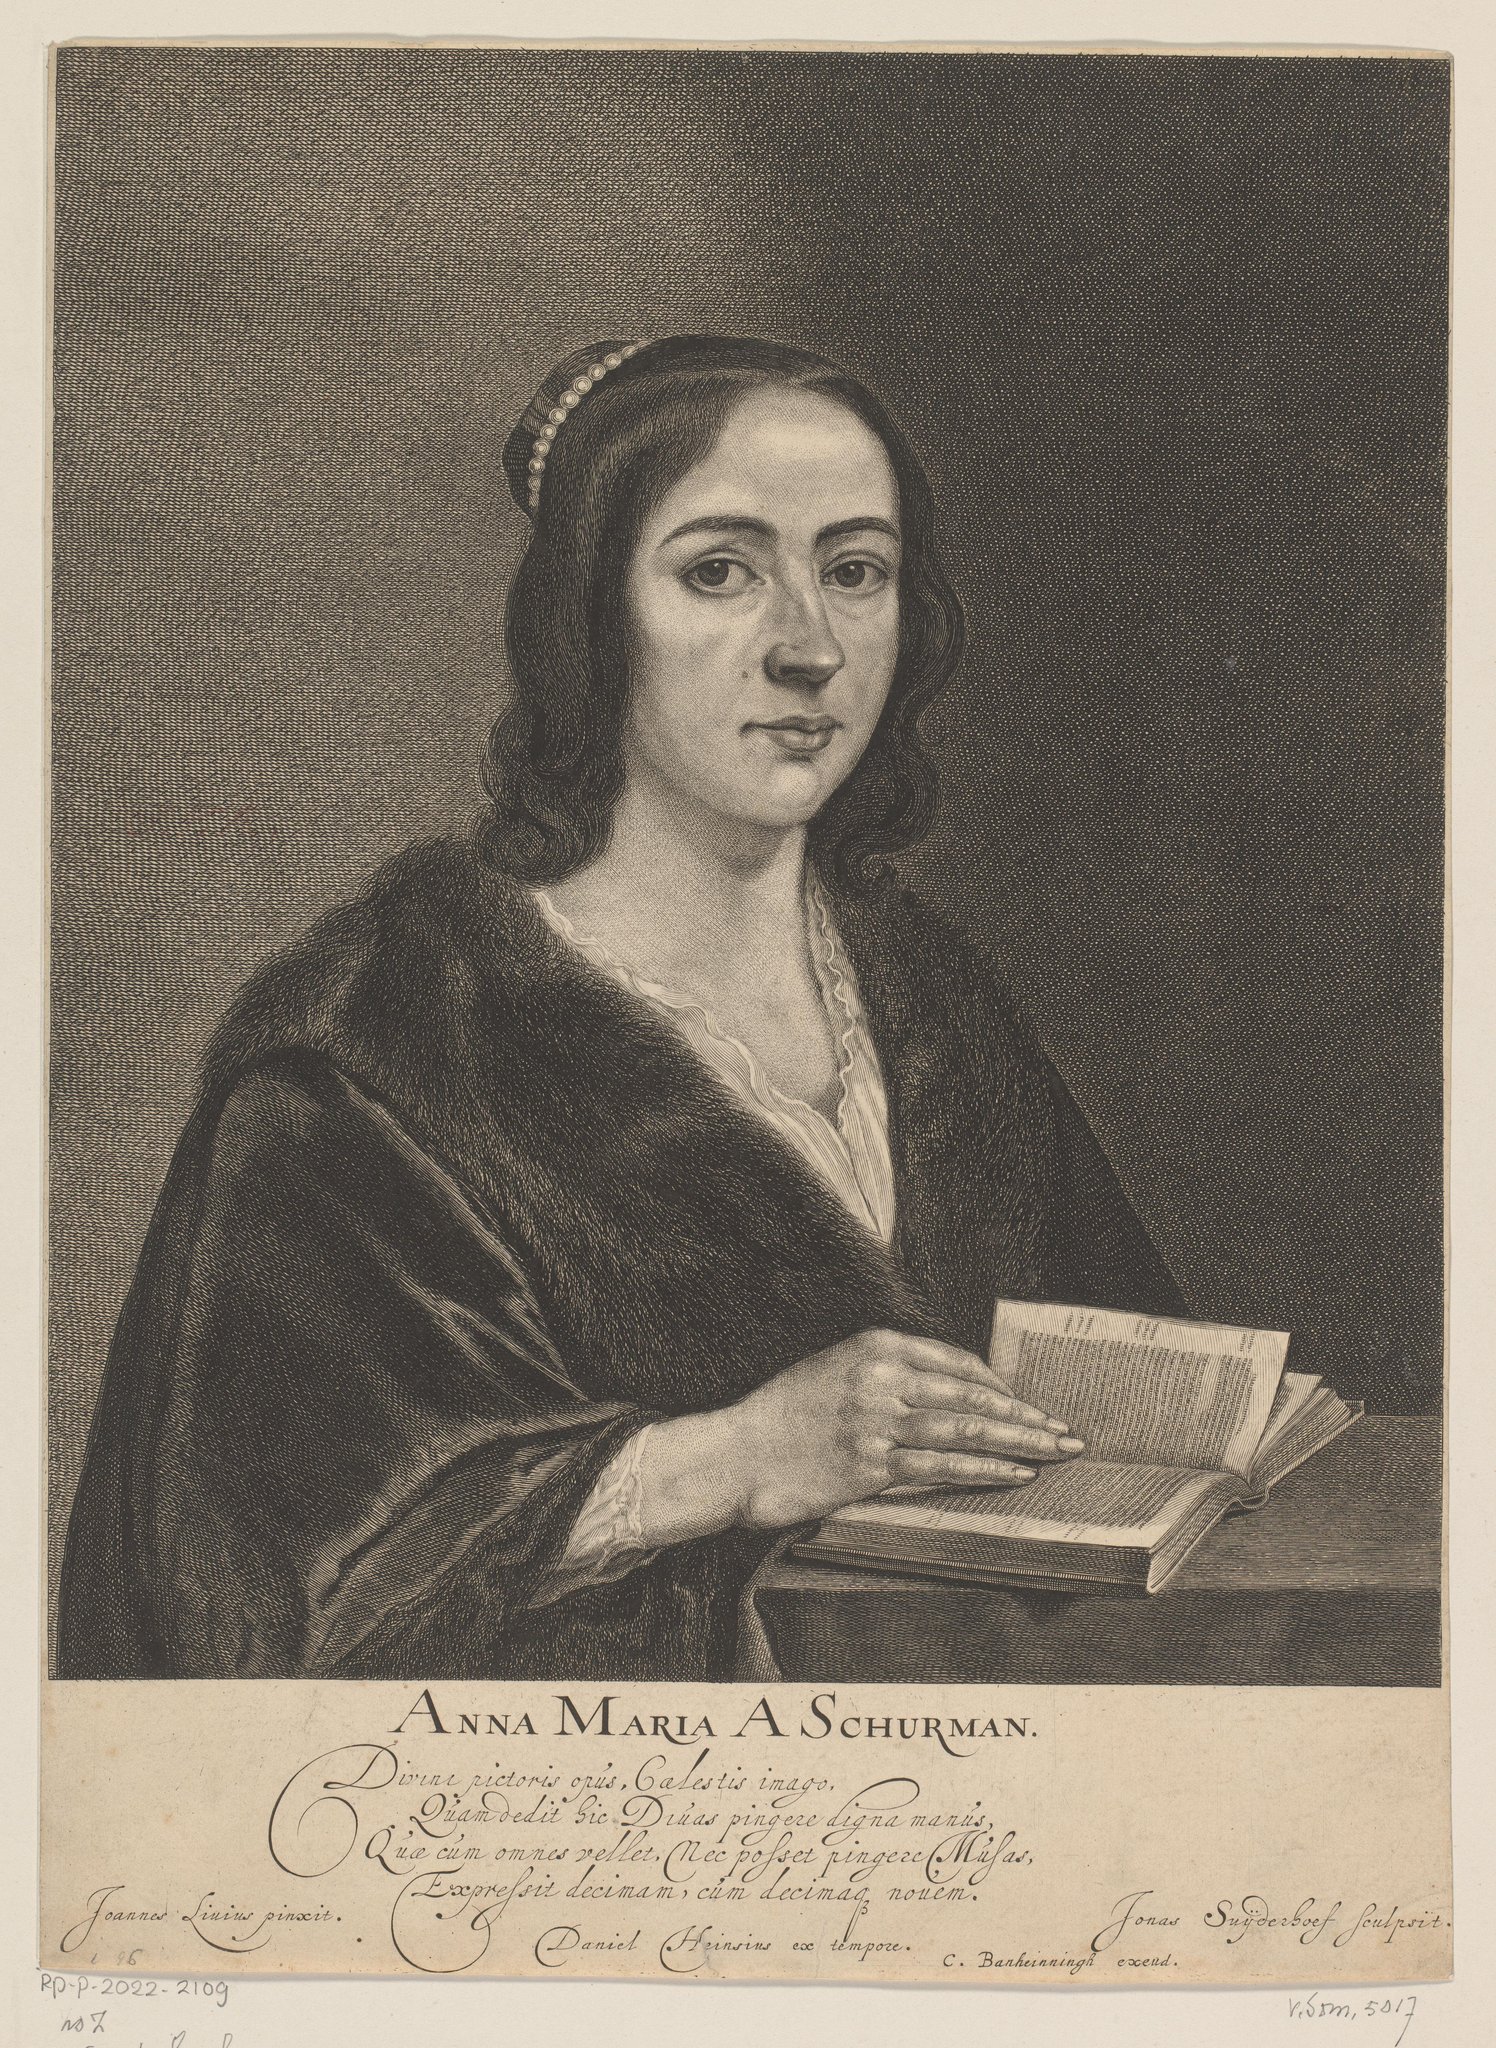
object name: print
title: Portret van Anna Maria van Schurman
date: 1649-1657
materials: paper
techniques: engraving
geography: haarlem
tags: cologne, print maker, draughtsman, anna maria van schurman, historical persons - bb - woman, portrait, self-portrait of artist, writer, poet, author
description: Met vierregelig onderschrift in het Latijn.